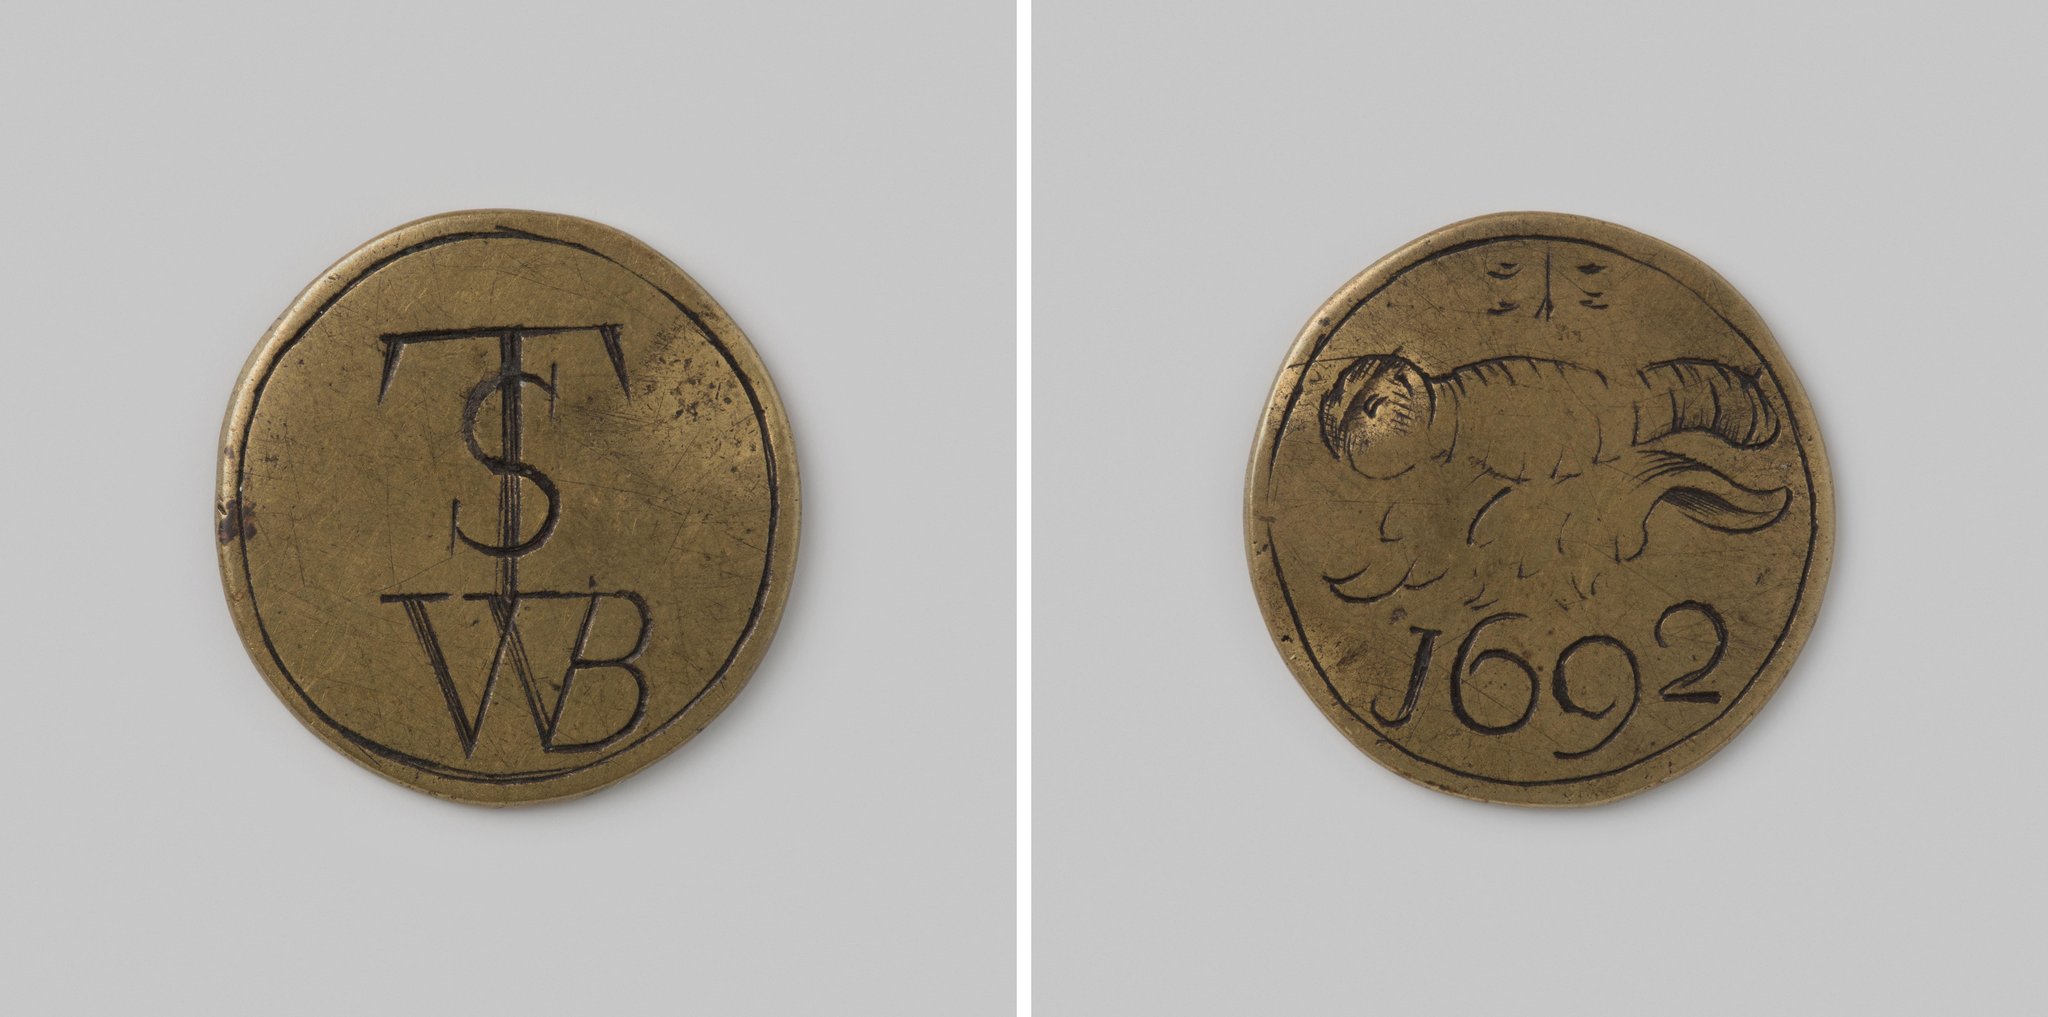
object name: medal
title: Presentiepenning van het Stofjeswerkersgilde te Utrecht, 1692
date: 1692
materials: brass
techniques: engraving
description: Ronde plaat messing gegraveerd op de voorzijde met STWB-monogram, op de keerzijde een zijderups op een blad boven 1692